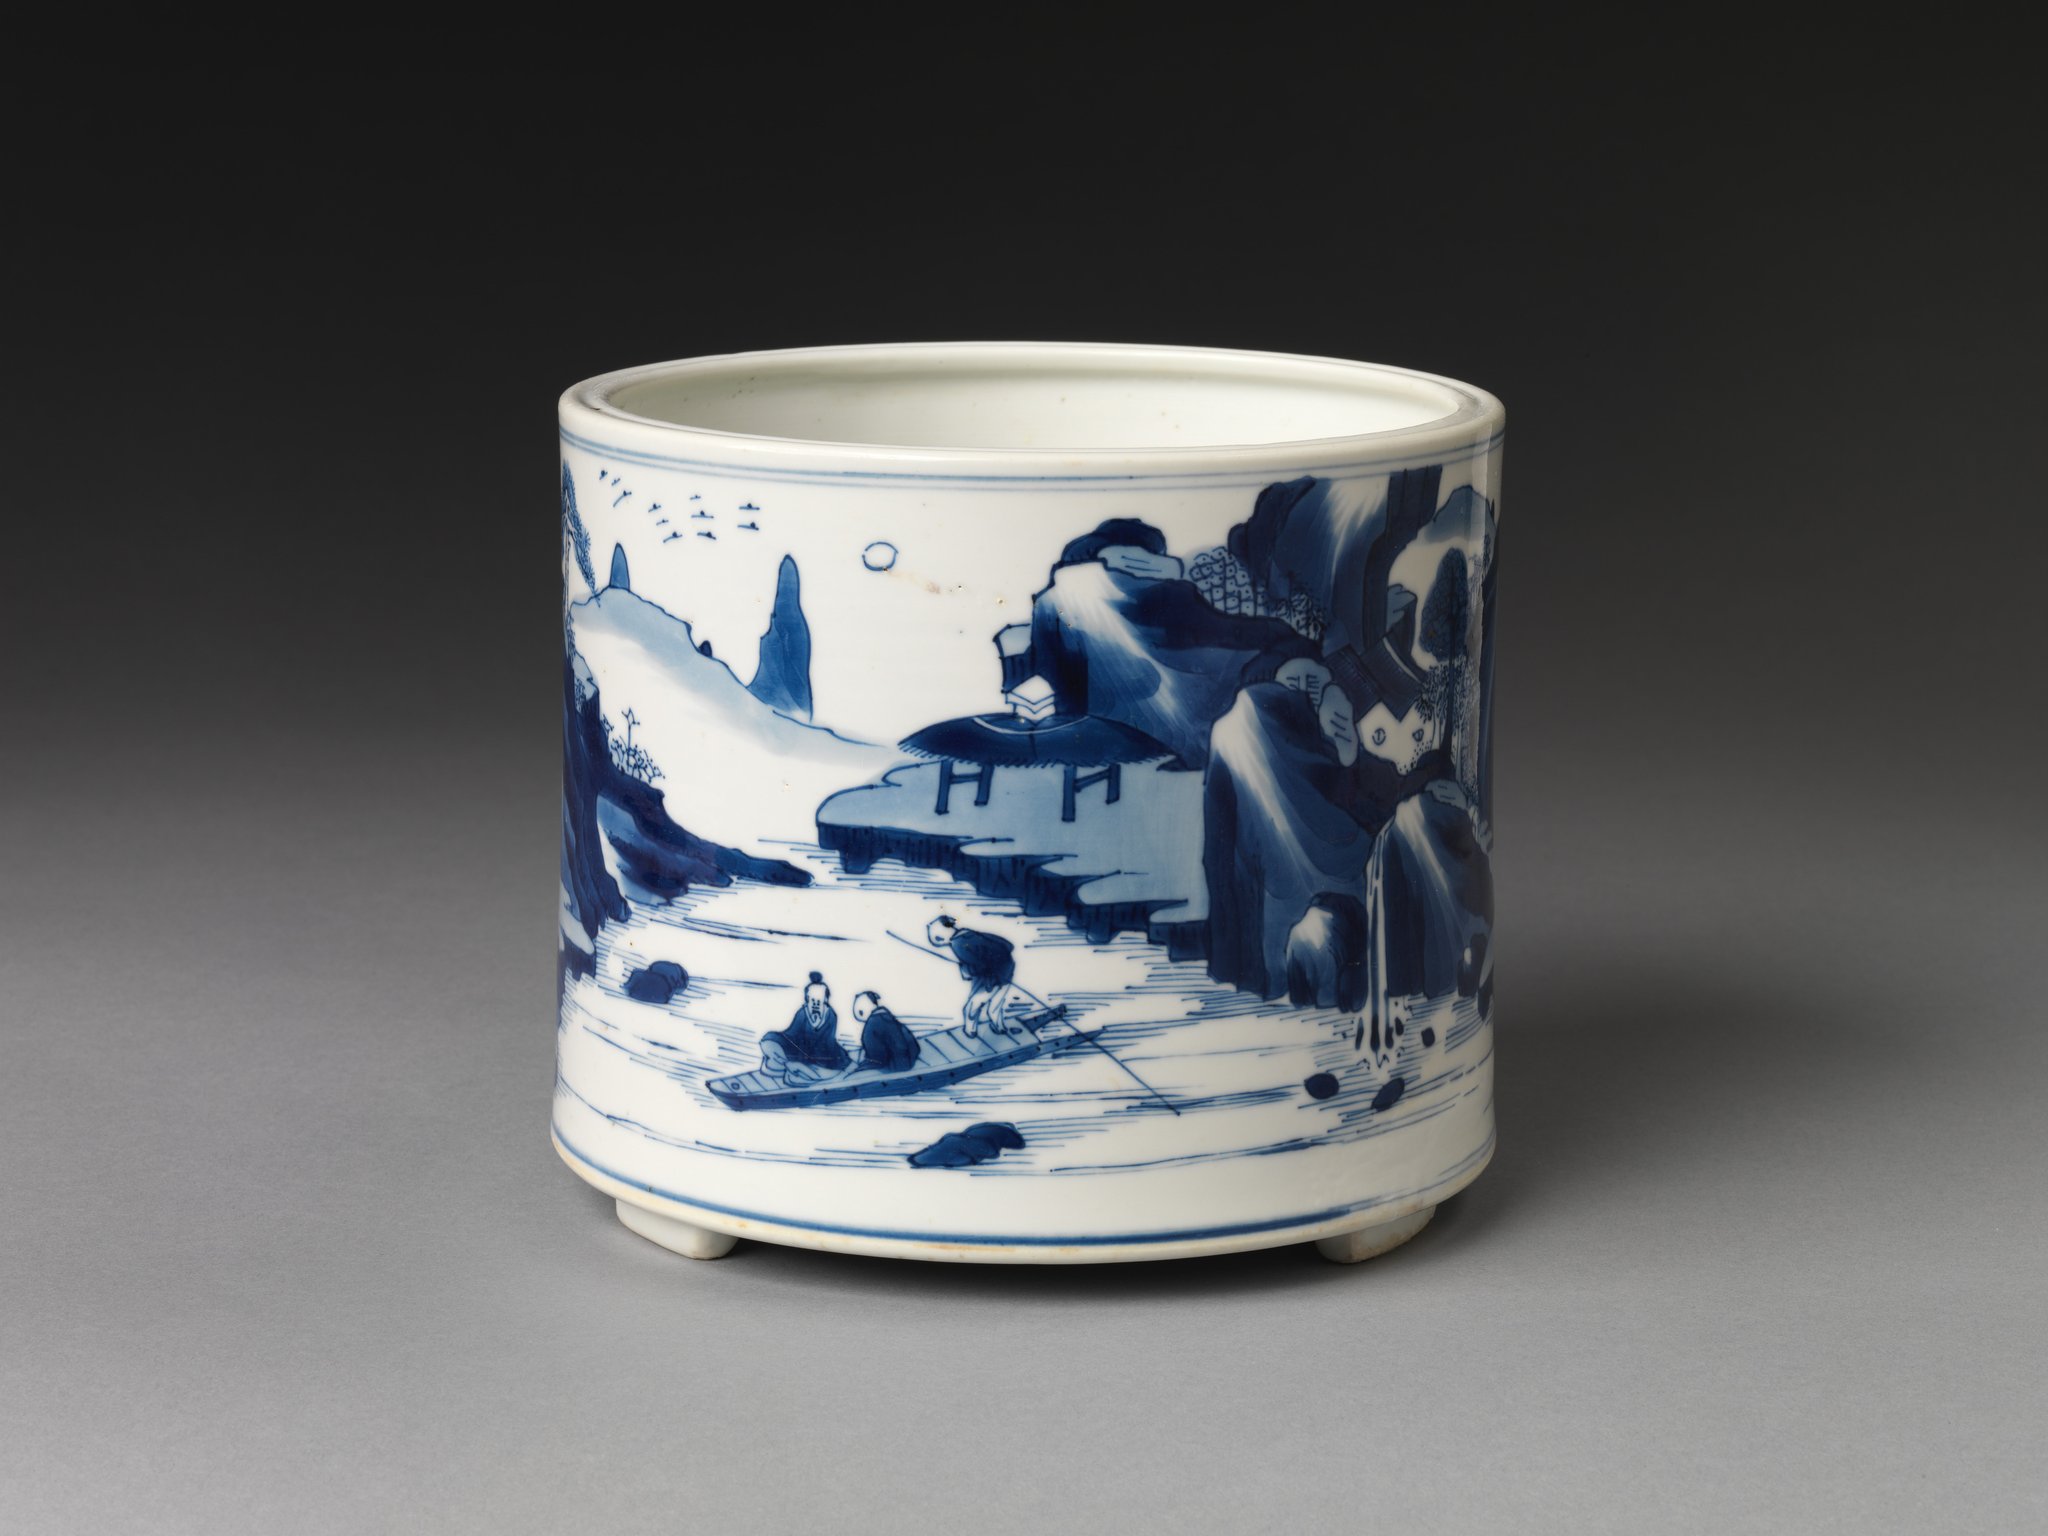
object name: censer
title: Censer with figures in landscape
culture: chinese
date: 1707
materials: cobalt, porcelain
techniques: painting, underglaze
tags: human figures,landscapes,censers